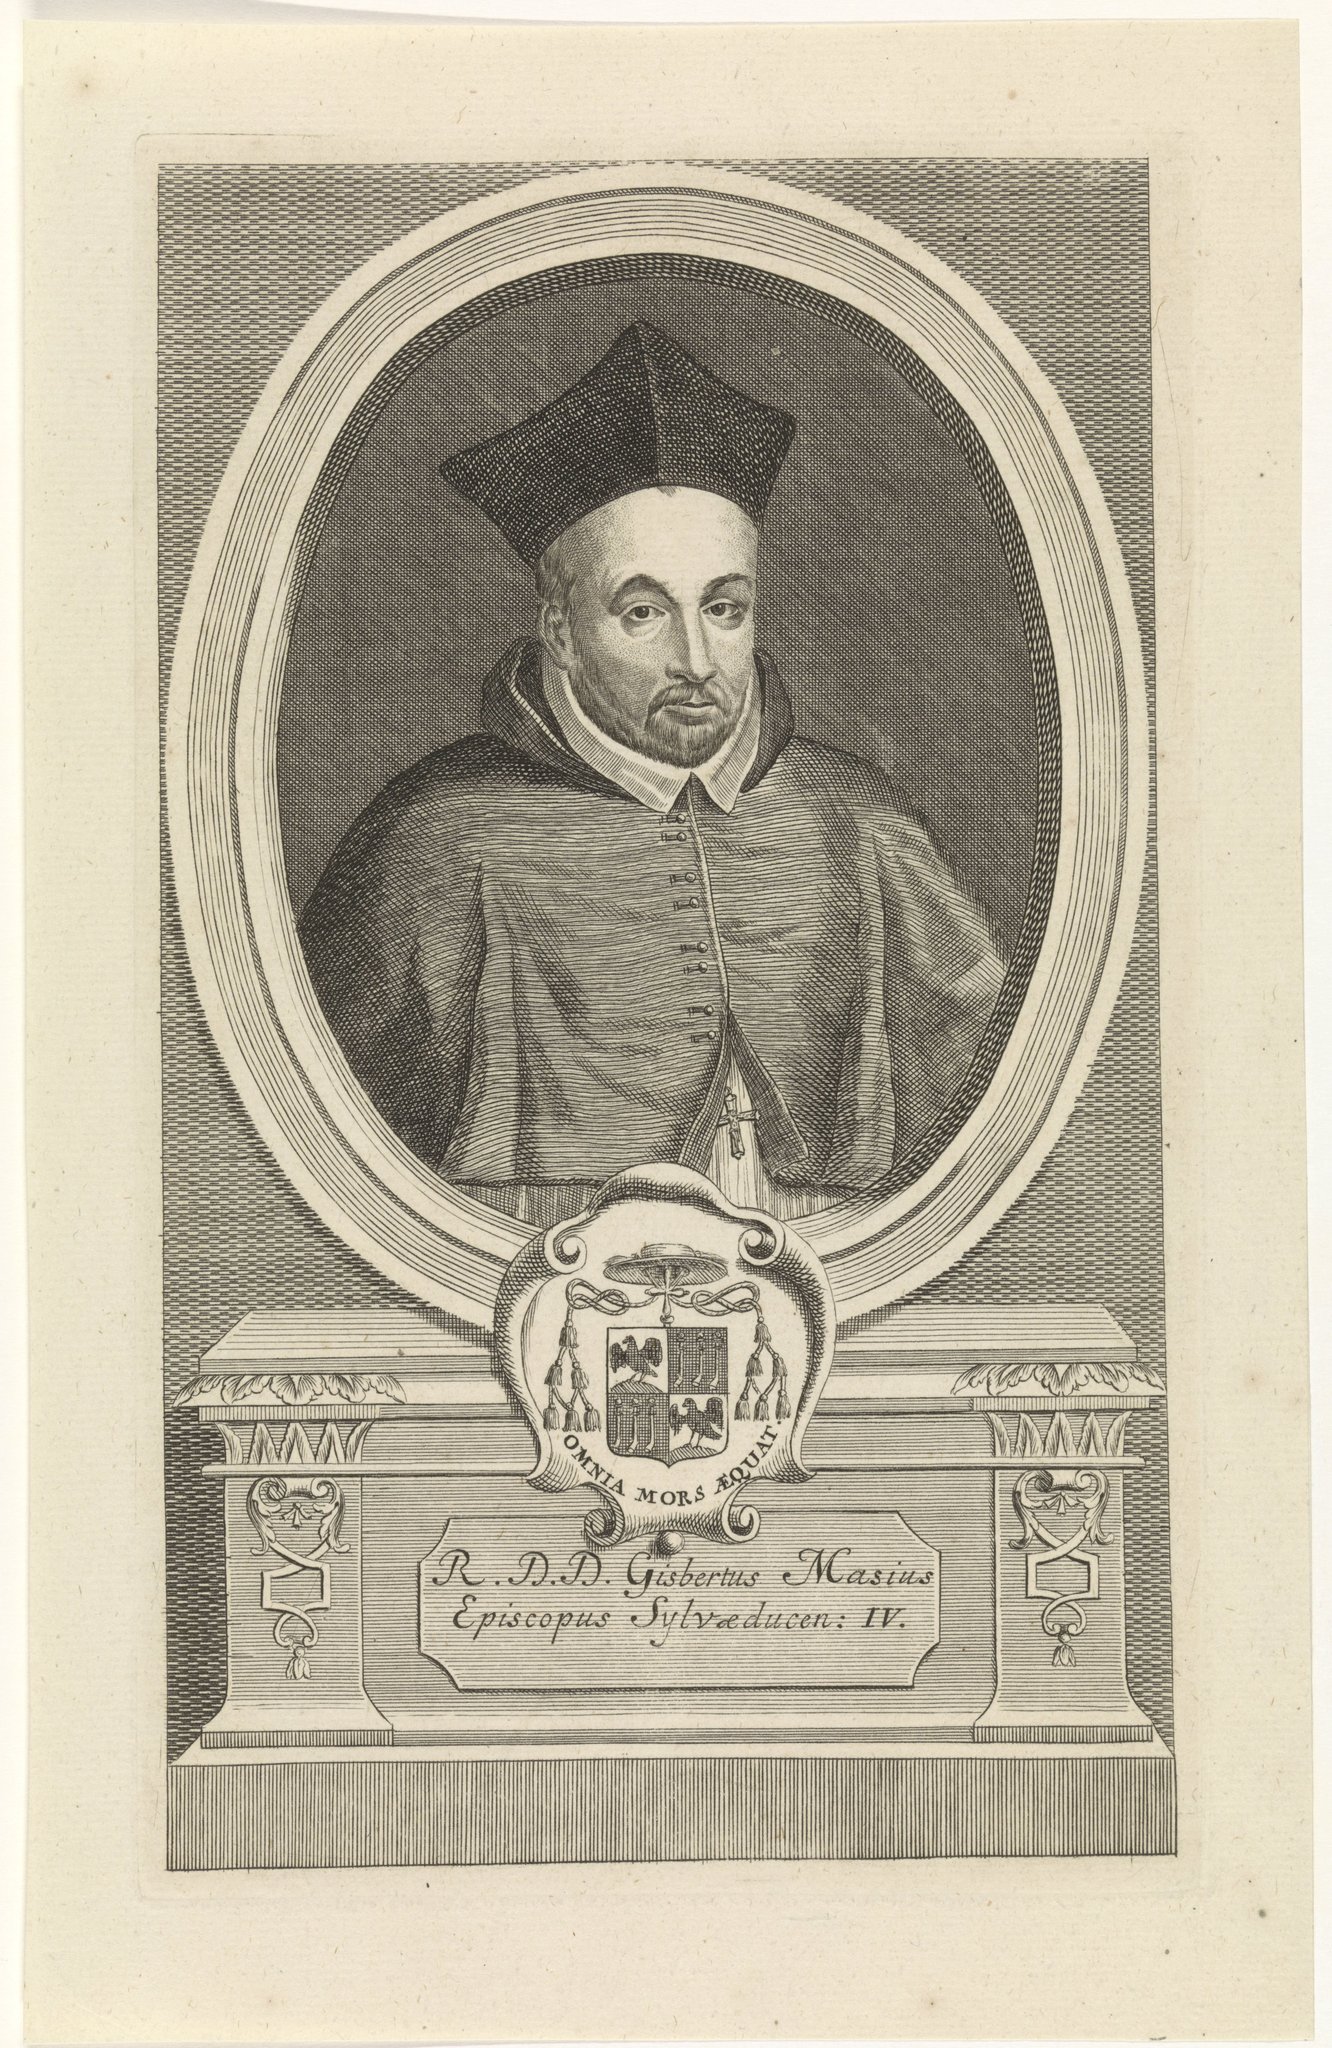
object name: book illustration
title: Portret van Ghisbertus Masius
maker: jan baptist jongelinx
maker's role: print maker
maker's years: 1689-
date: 1710-1725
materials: paper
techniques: engraving, etching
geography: antwerp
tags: den bosch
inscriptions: collector's mark: Lugt 2228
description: Busteportret van de bisschop Gijsbertus Masius, met biretta. Het portret is gevat in een ovale omlijsting met het wapenschild van de geportretteerde en een motto in het Latijn. In een kader een tweeregelig onderschrift in het Latijn.